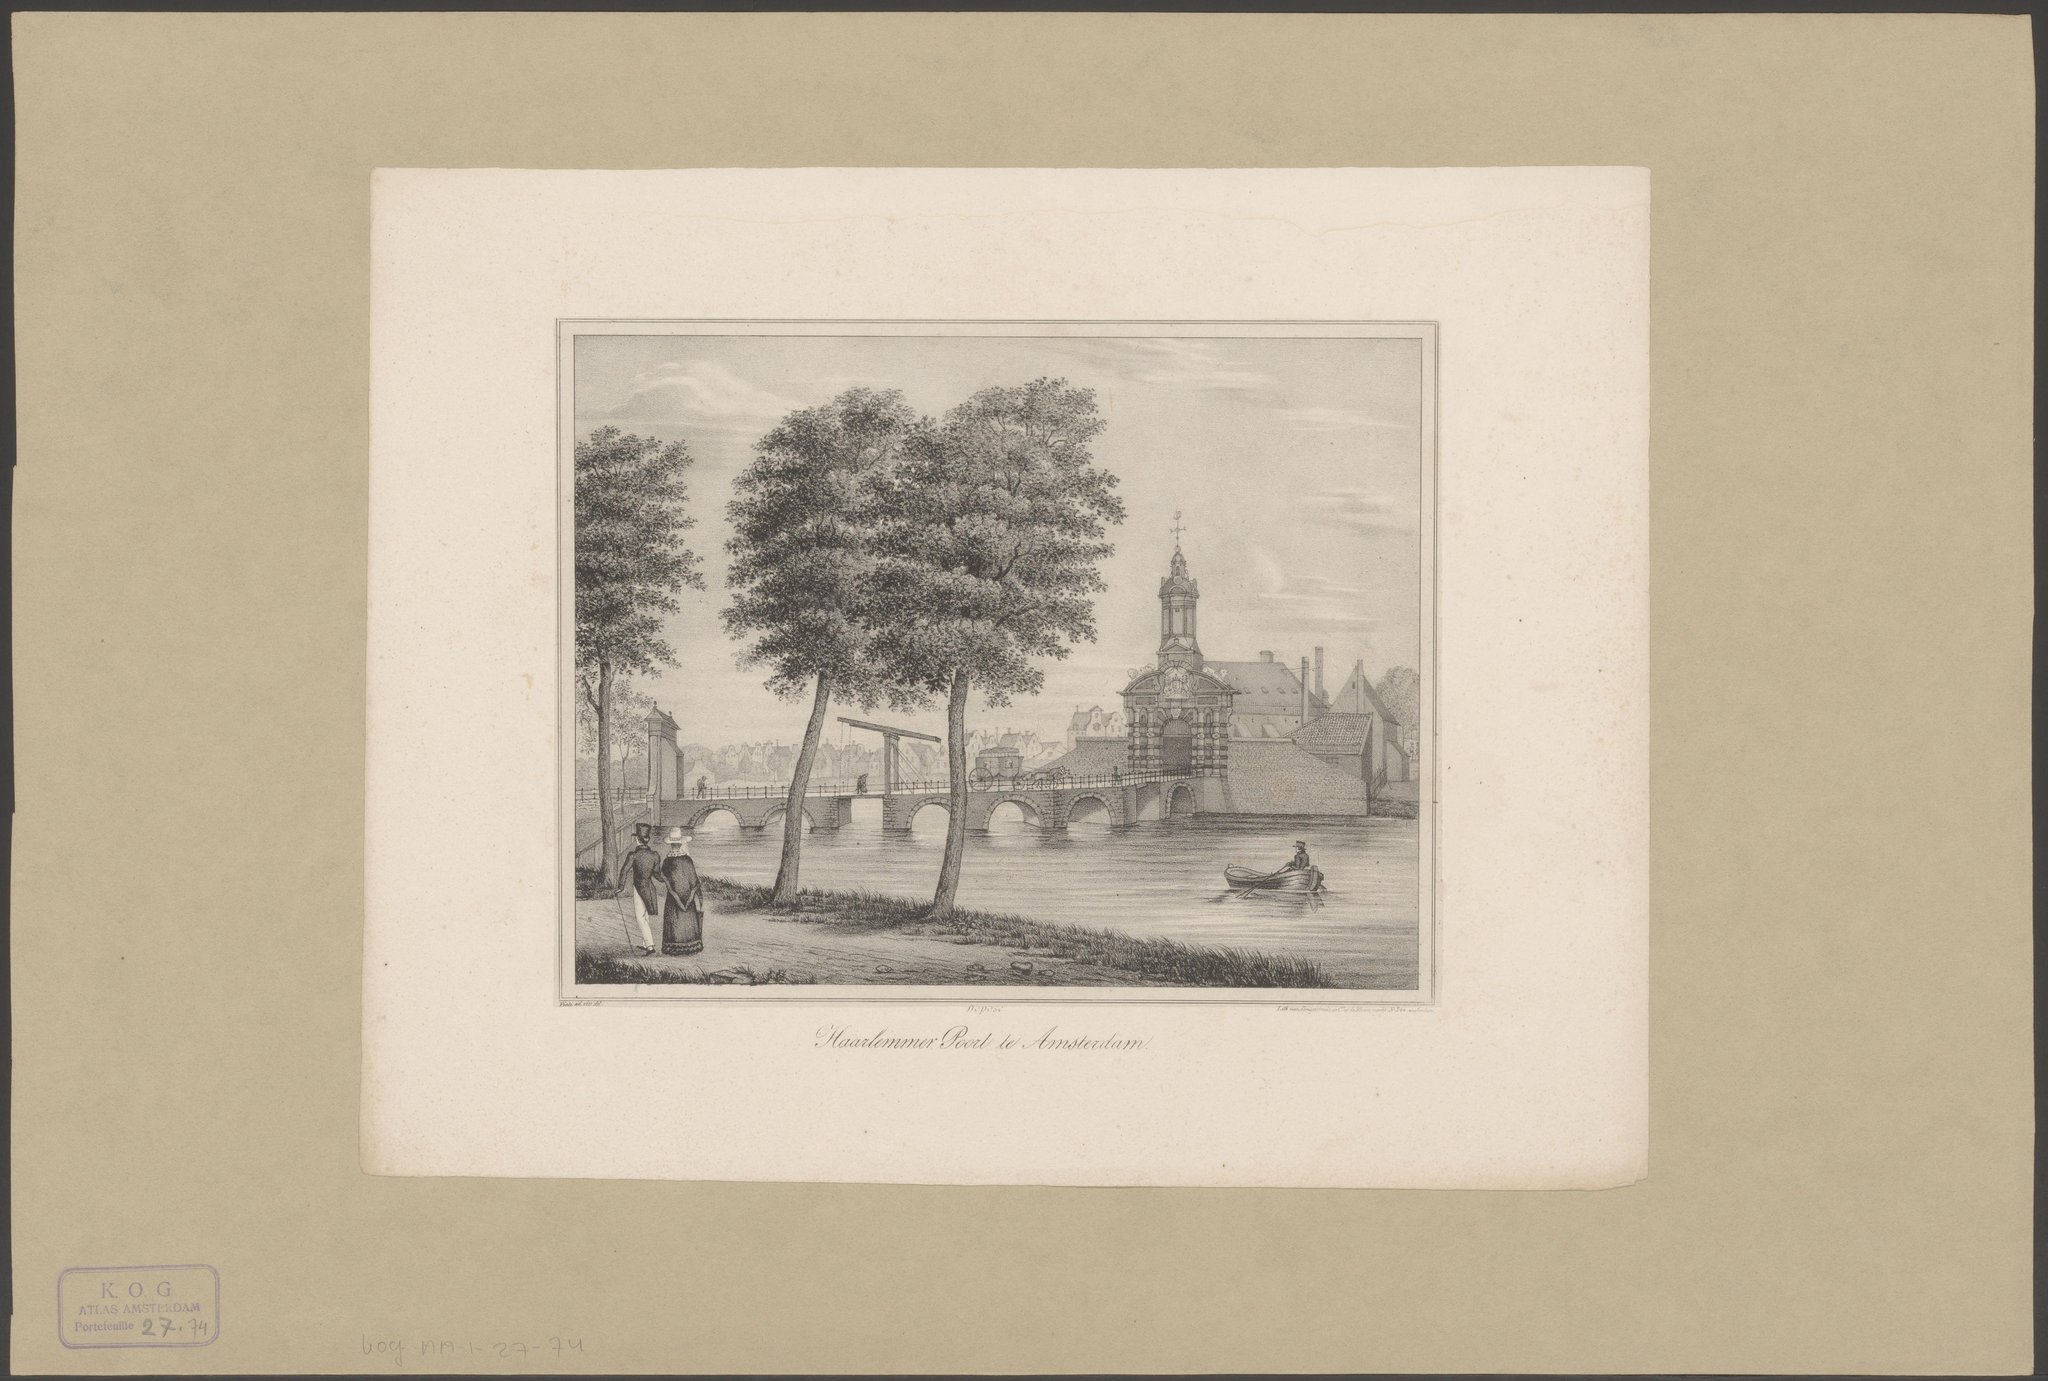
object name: print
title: Gezicht op de Haarlemmerpoort te Amsterdam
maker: m. pinte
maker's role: print maker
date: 1827-1900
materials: paper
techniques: lithograph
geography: amsterdam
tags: rowing-boat, canoe, etc., bridge in city across river, canal, etc.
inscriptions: collector's mark: Lugt 1641b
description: Onderwerpsrubriek binnen de Atlas Amsterdam: B. Poorten, verzamelbladen, D. Haarlemmerpoort(en).